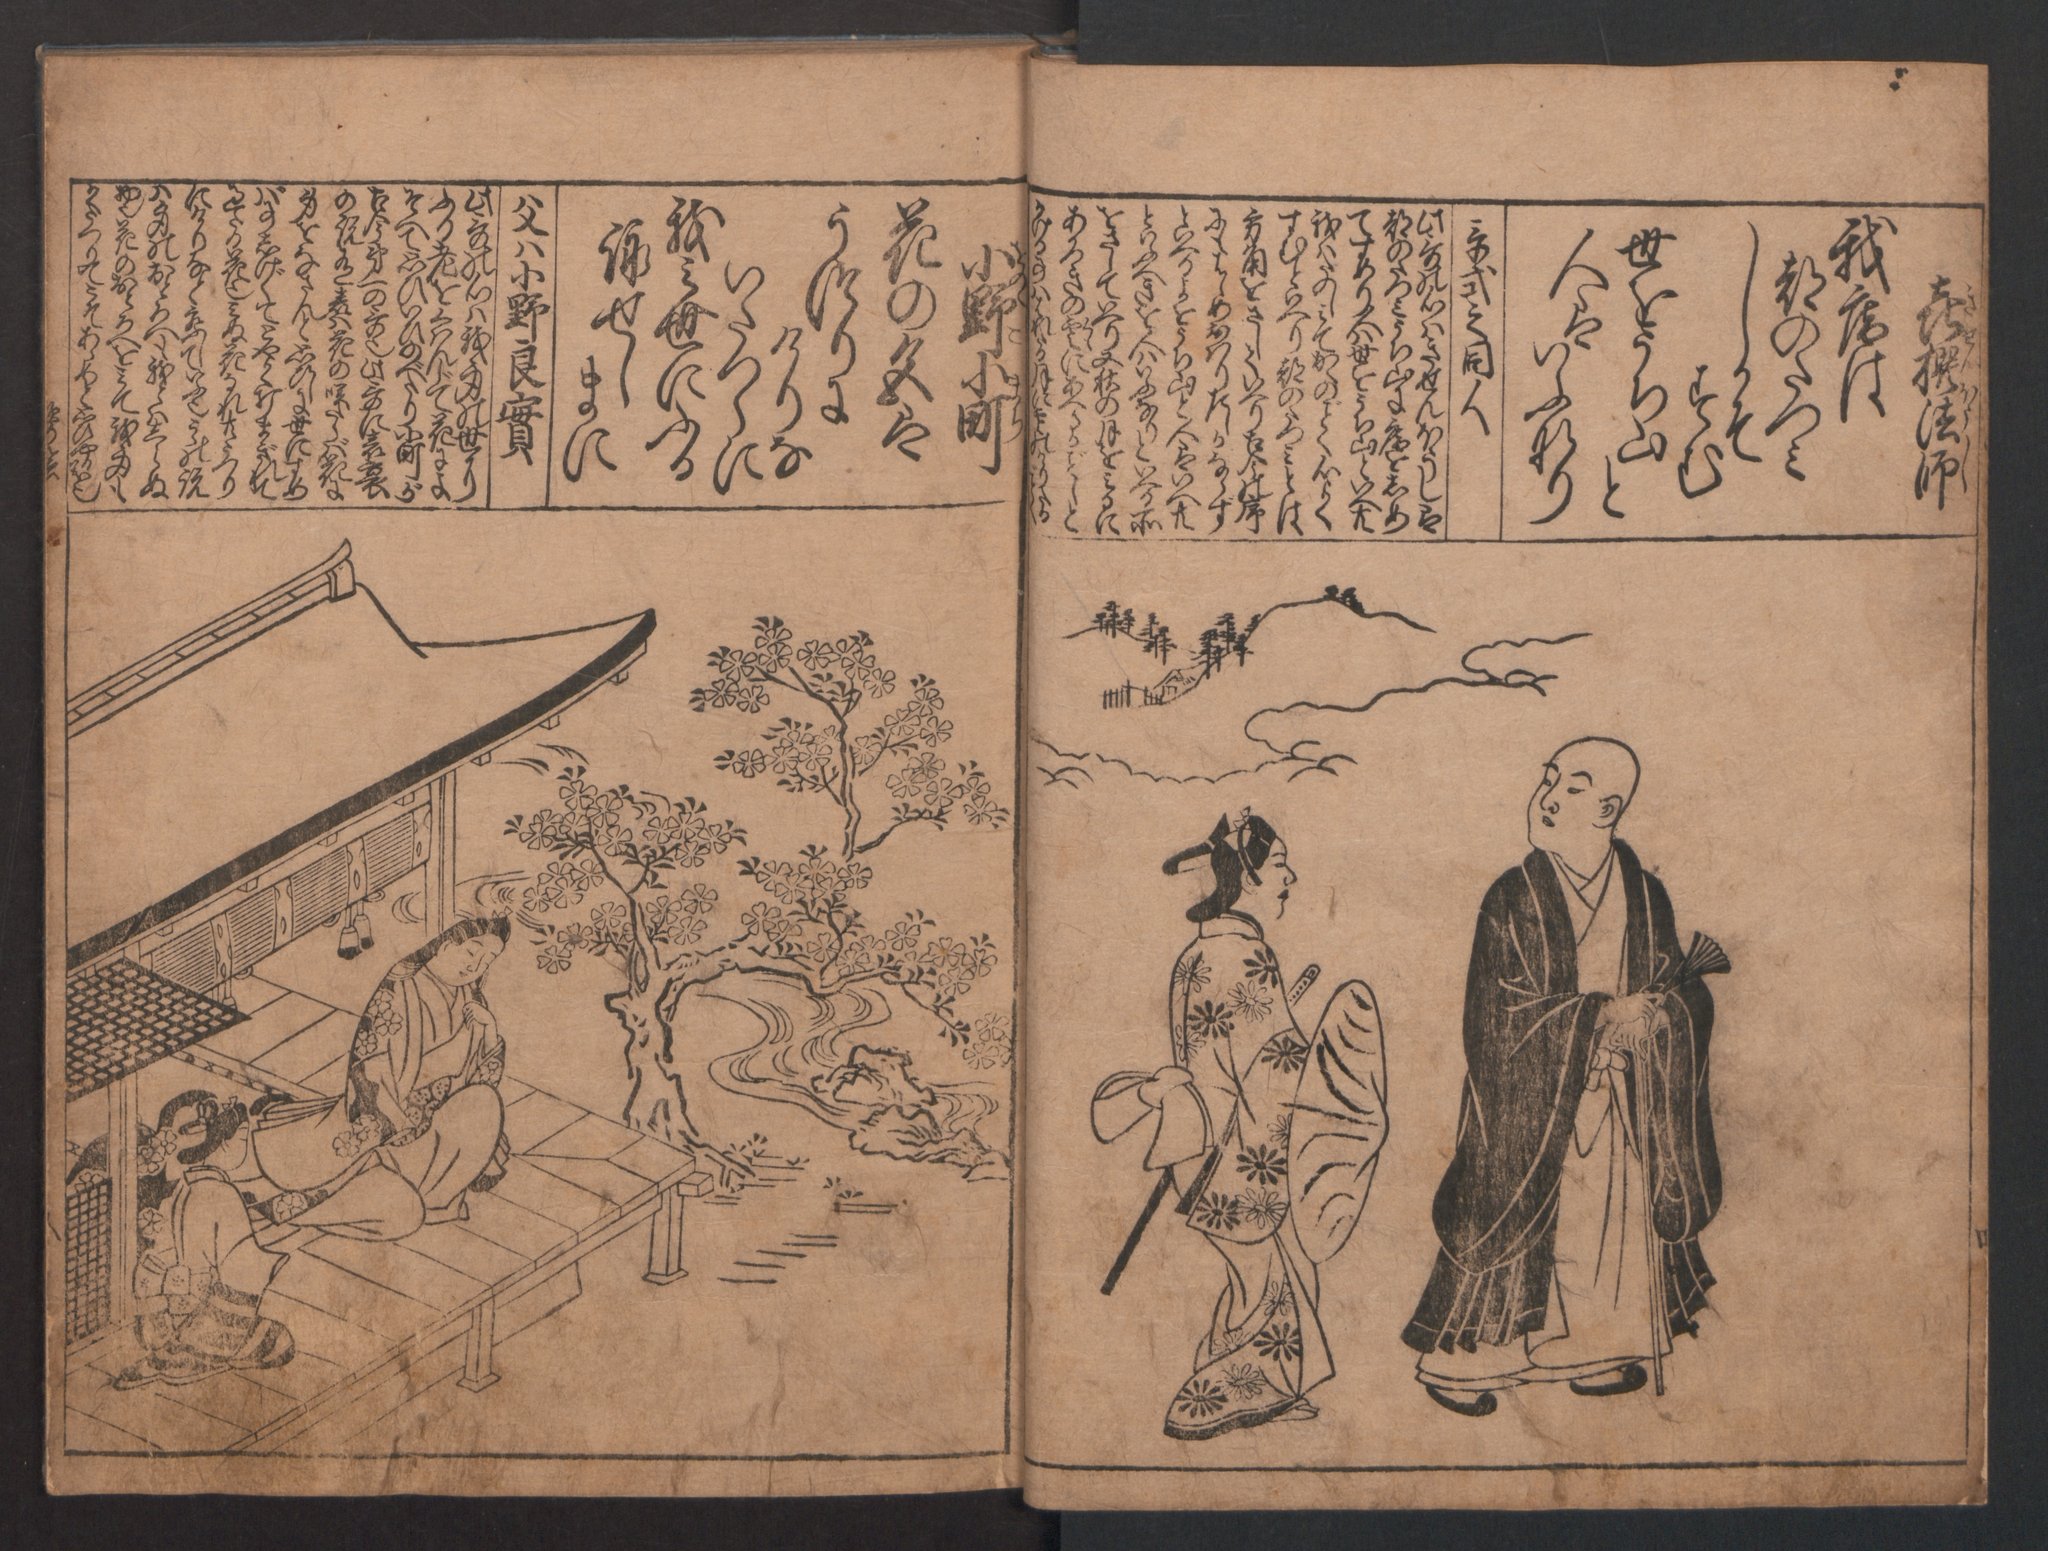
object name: illustrated book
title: Portraits for One Hundred Poems about One Hundred Poets (Sugata-e hyakunin isshu) 姿絵百人一首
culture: japanese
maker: hishikawa moronobu 菱川師宣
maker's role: artist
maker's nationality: japanese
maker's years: 1618-1694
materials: ink, paper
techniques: woodblock print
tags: poetry,men,women,trees